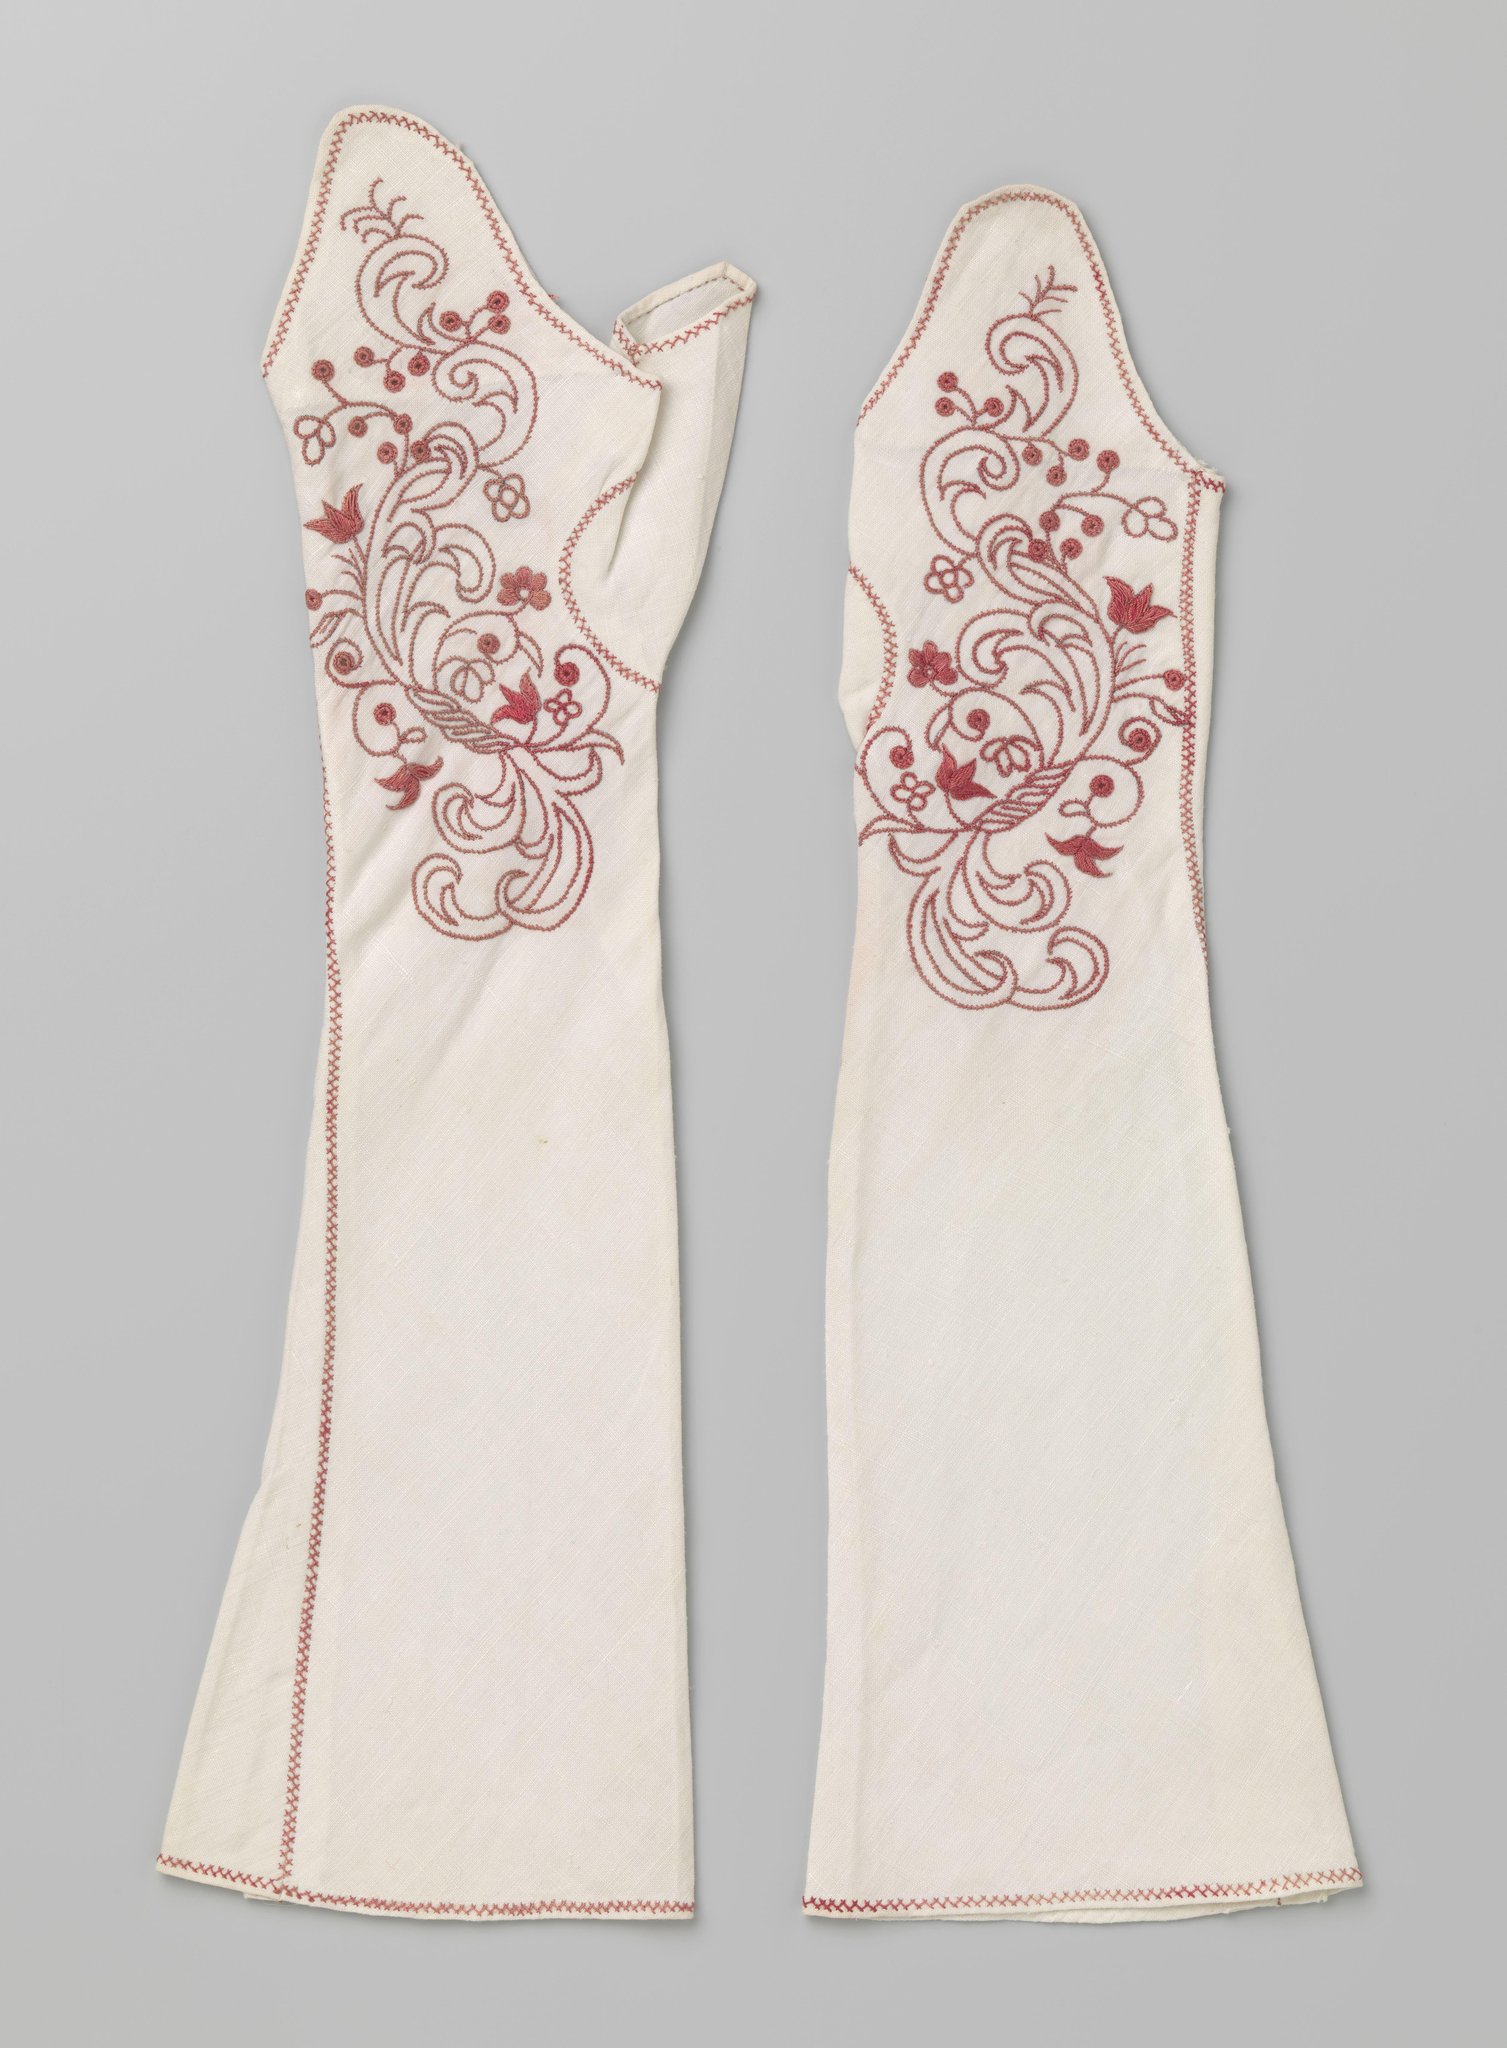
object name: clothing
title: Mitaine van witte keperkatoen en linnen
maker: Anonymous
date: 1750-1800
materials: cotton, linen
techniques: embroidered, weave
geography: northern netherlands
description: Paar lange mitaines van keperkatoen en linnen. werk. Schuin uit de stof geknipt. Gevoerde punt die over de handrug valt. Ingezette duim zonder top. Rood borduurwerk. Groot vlak over de handrug , pols en onderarm versierd met een rokoko van een opgelegd koordje gemaakte tak, die dubbel S-vormig gezwenkt is met uitlopers. De tak is in ongevulde contouren aangegeven. Kleine zijhechtrankjes eindigen in een tulpje, rozetjes en besjes.